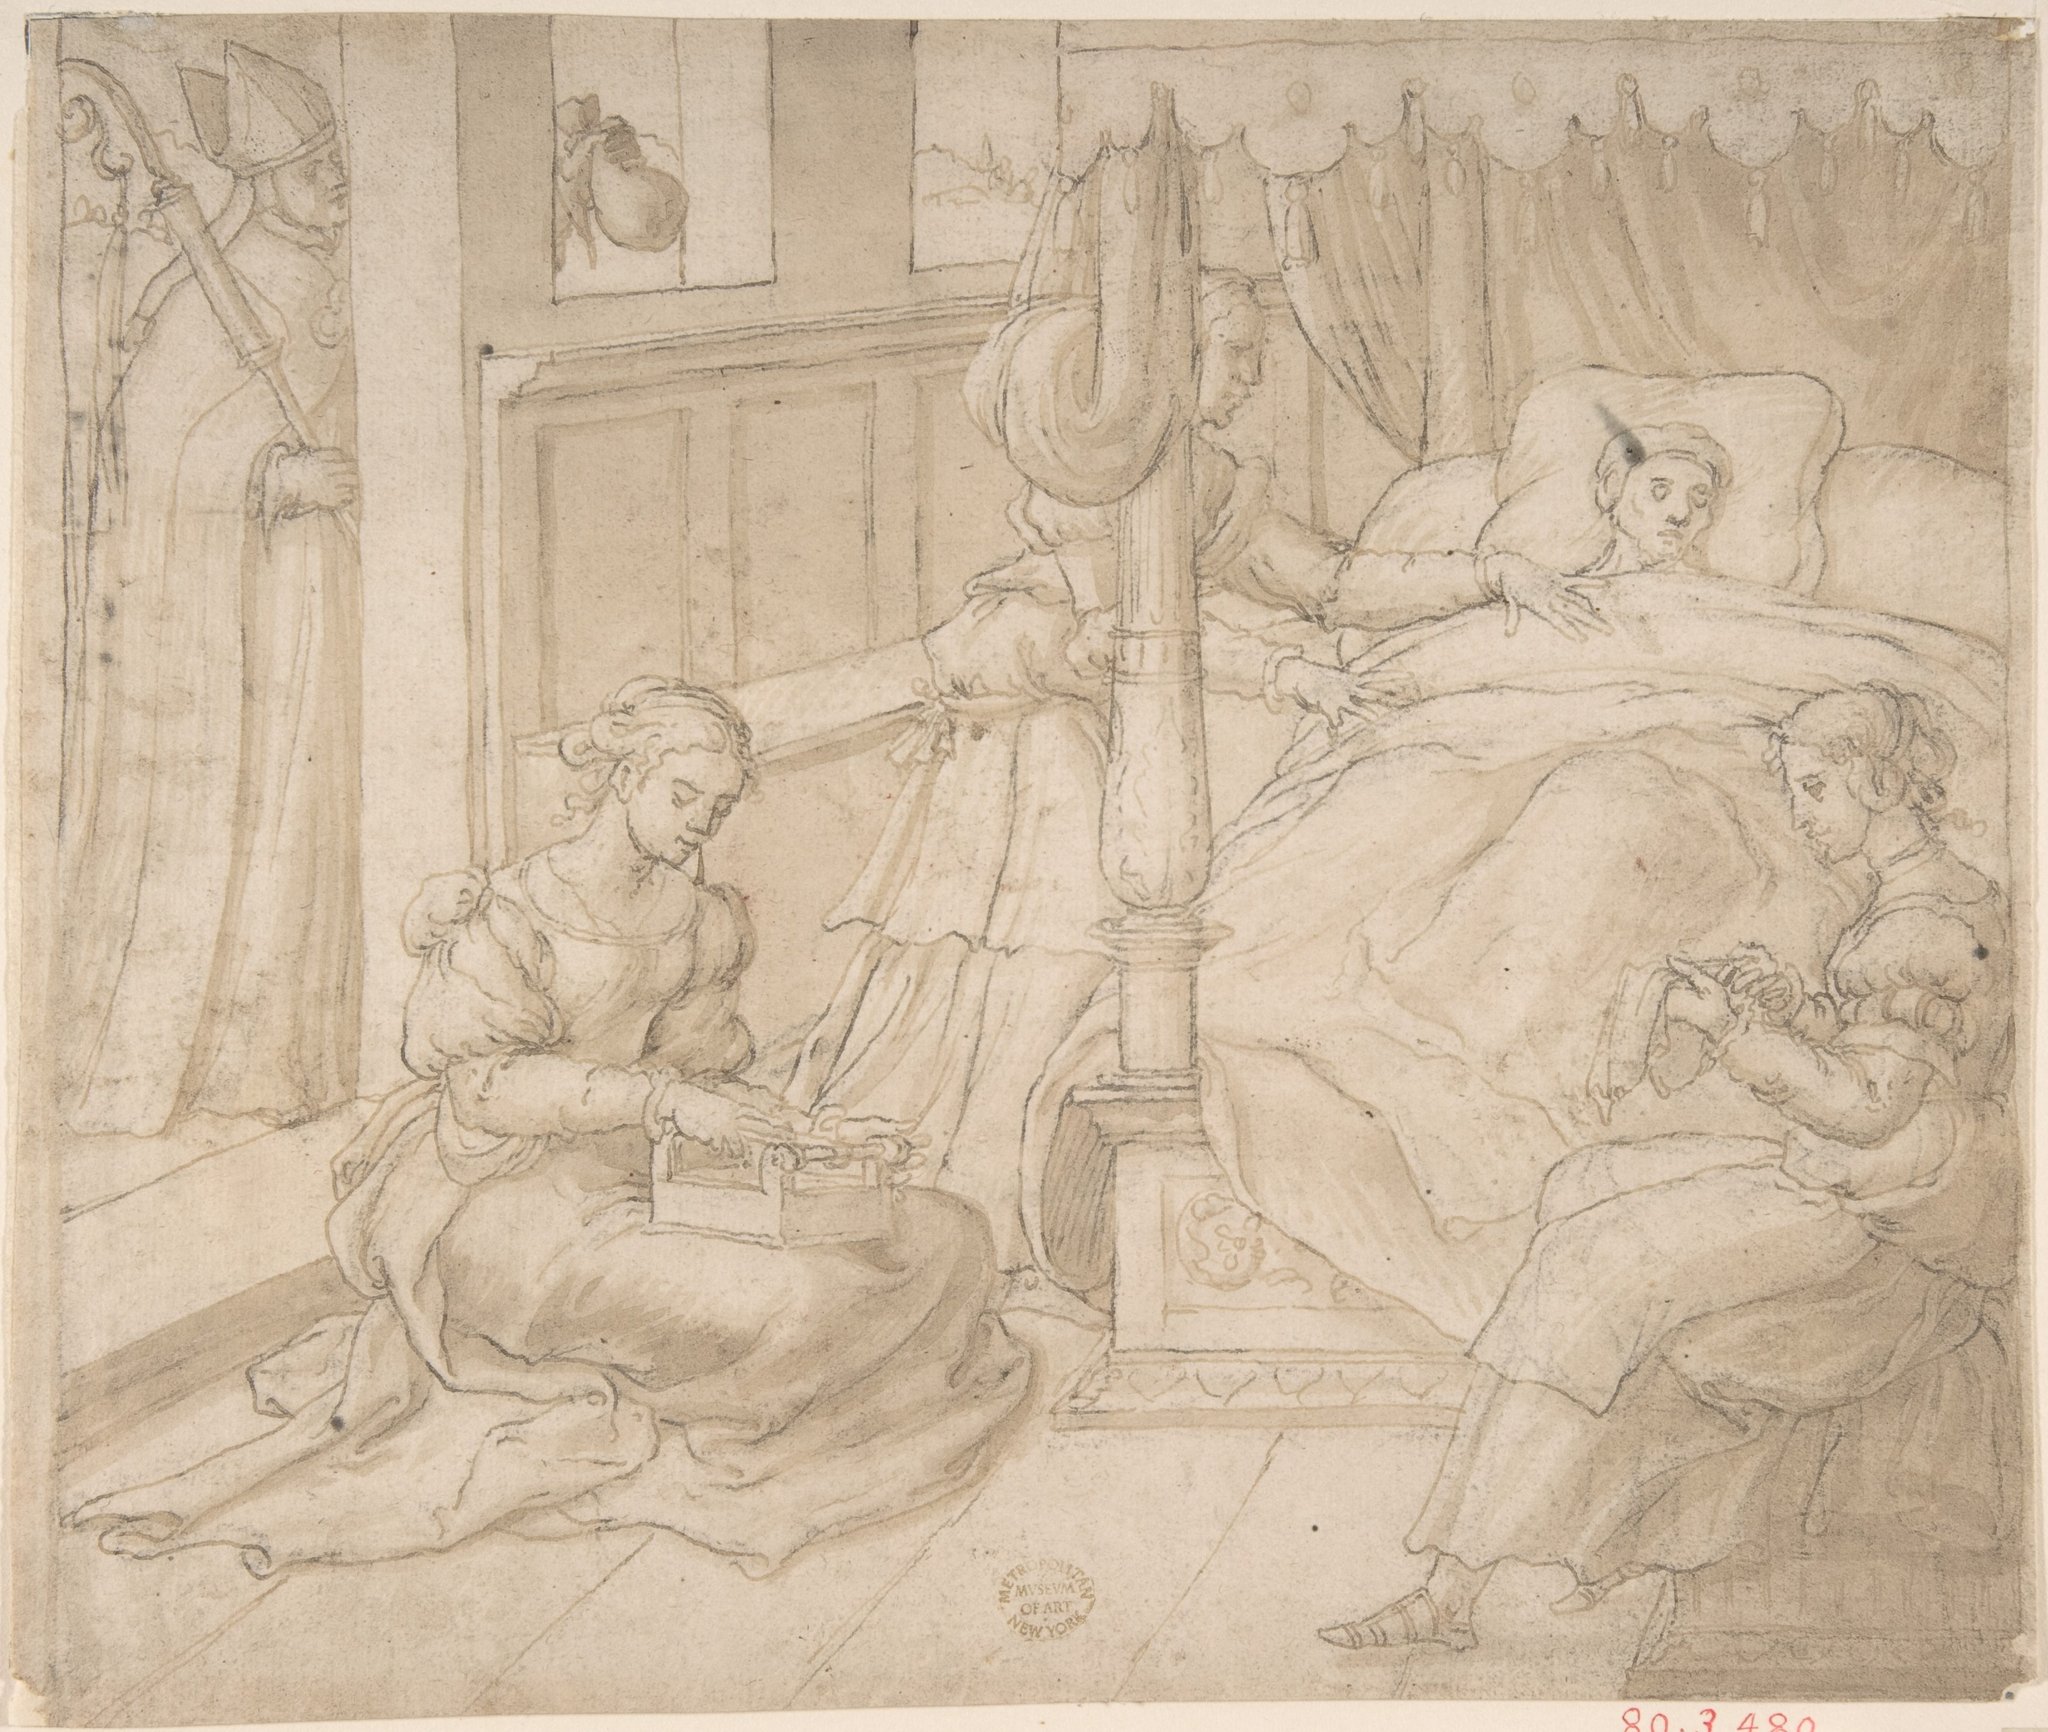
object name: drawing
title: St. Nicholas and the Three Daughters of the Poor Gentleman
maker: jan swart van groningen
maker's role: artist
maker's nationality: netherlandish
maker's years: 1490-1553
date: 1501-1600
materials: ink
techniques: pen, wash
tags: bedrooms,illness,men,women,saints